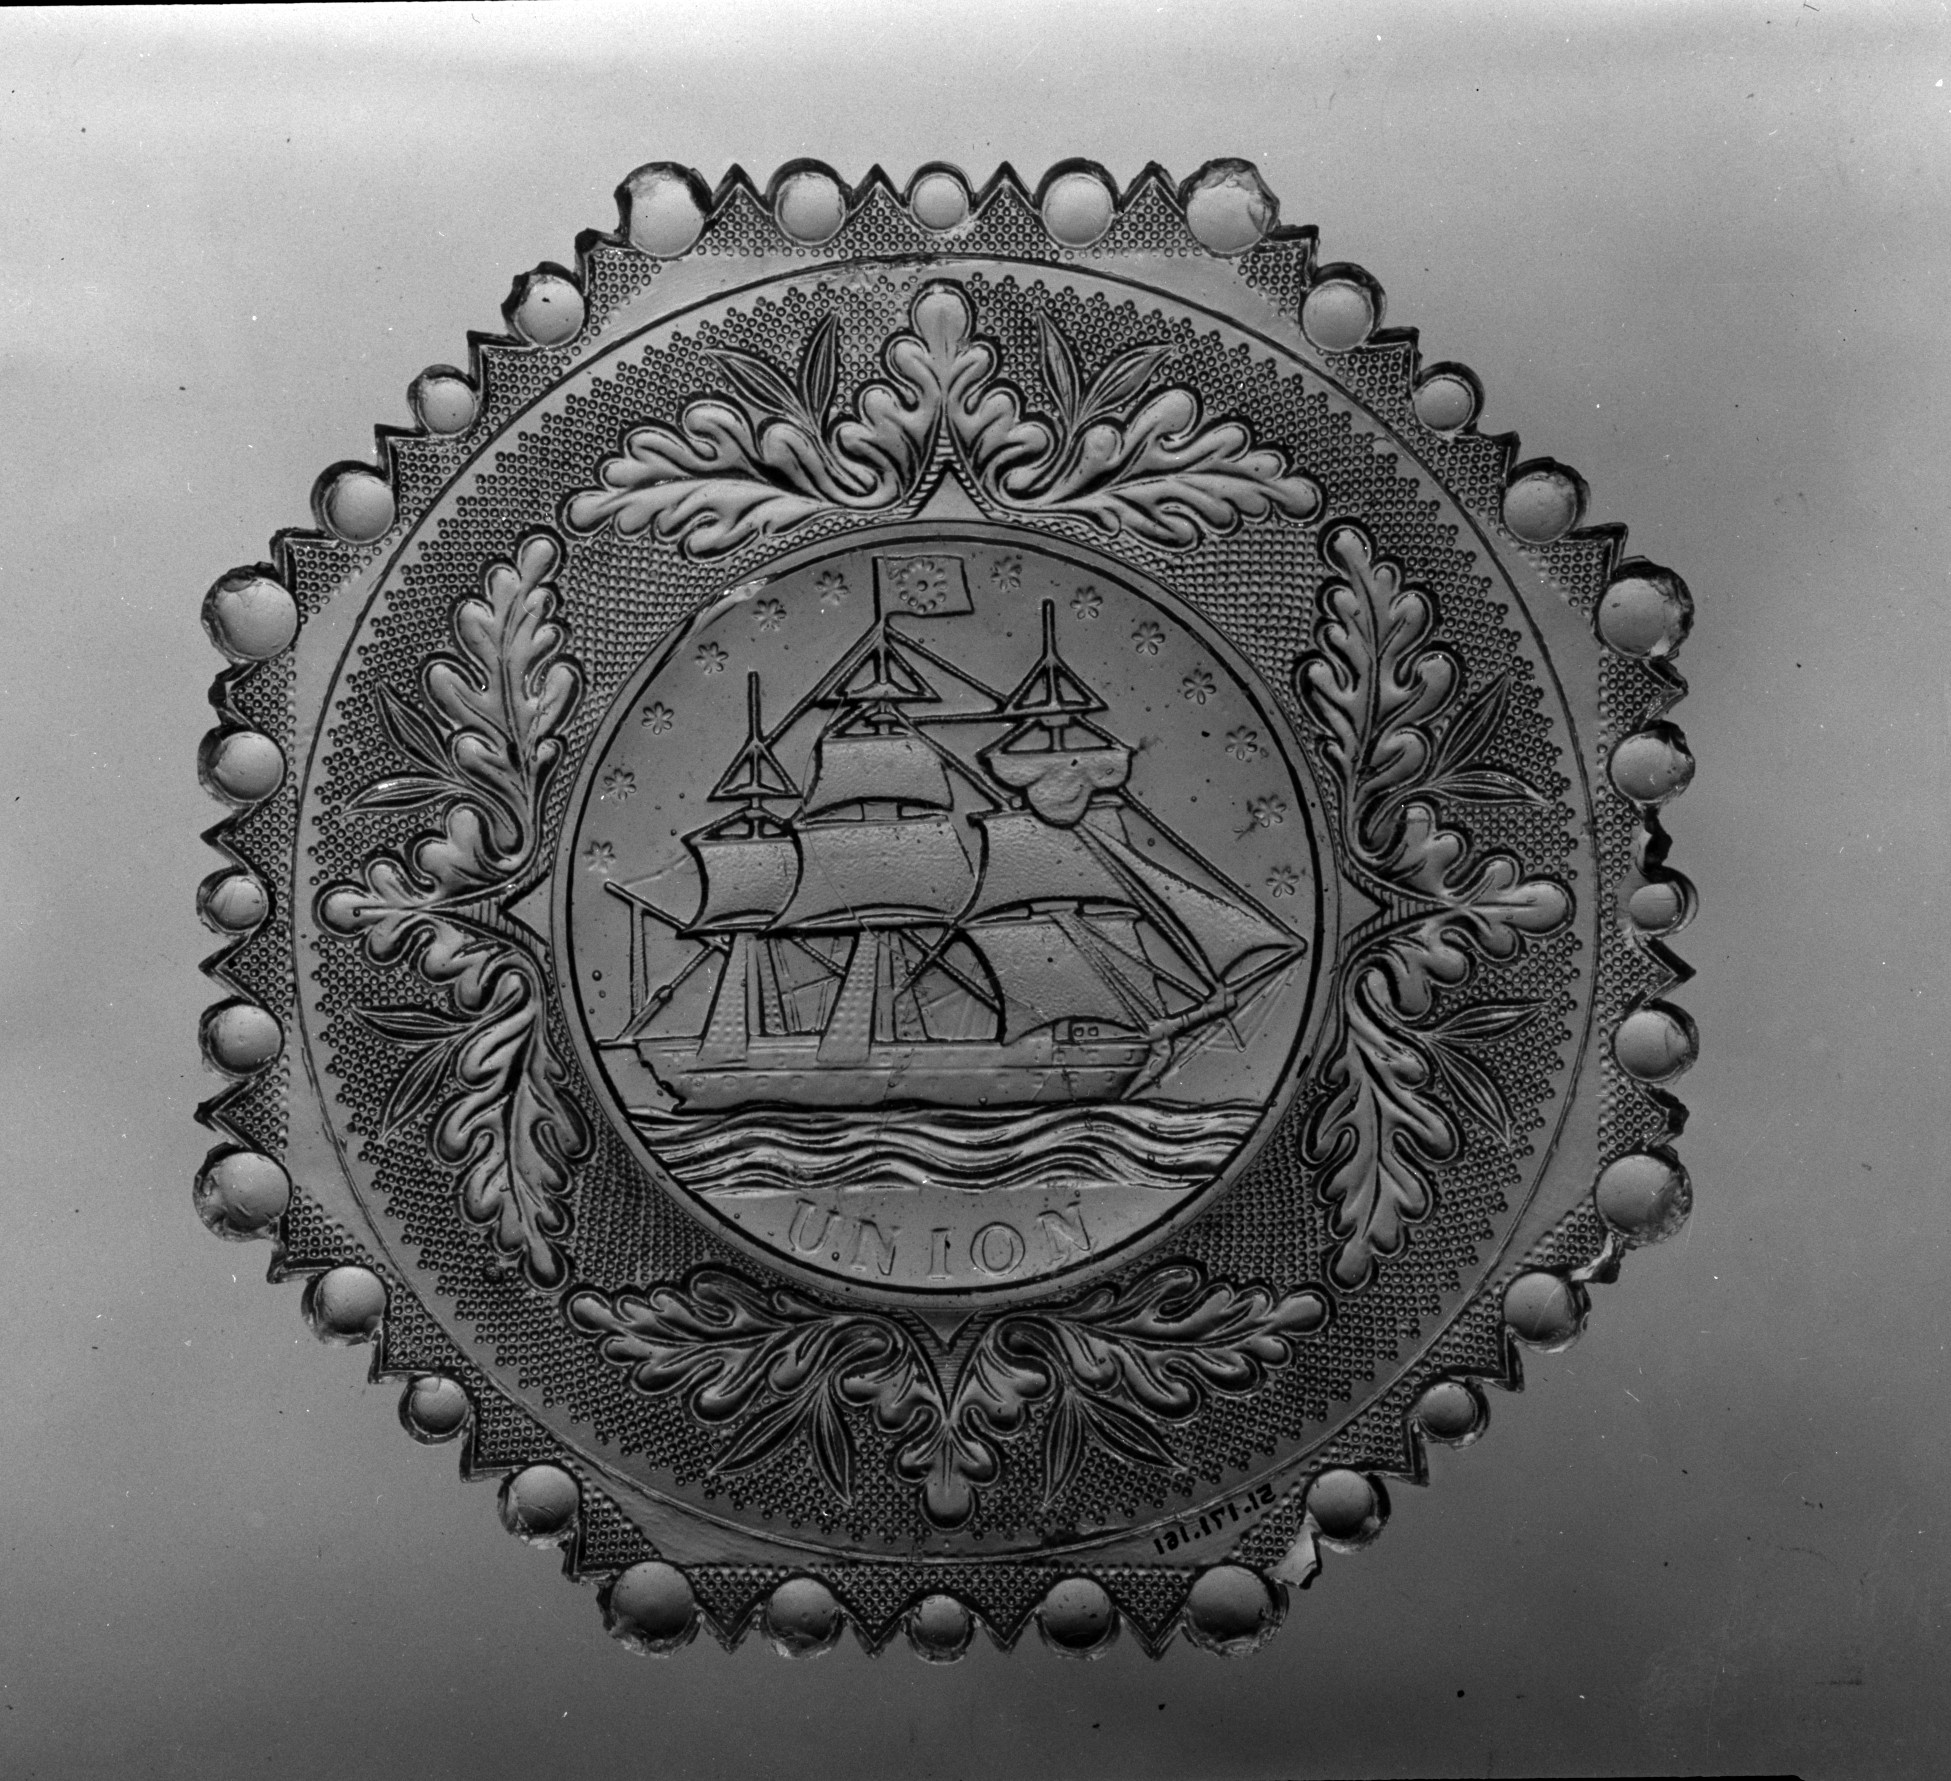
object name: plate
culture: american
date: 1830-1845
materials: glass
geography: united states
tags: ships